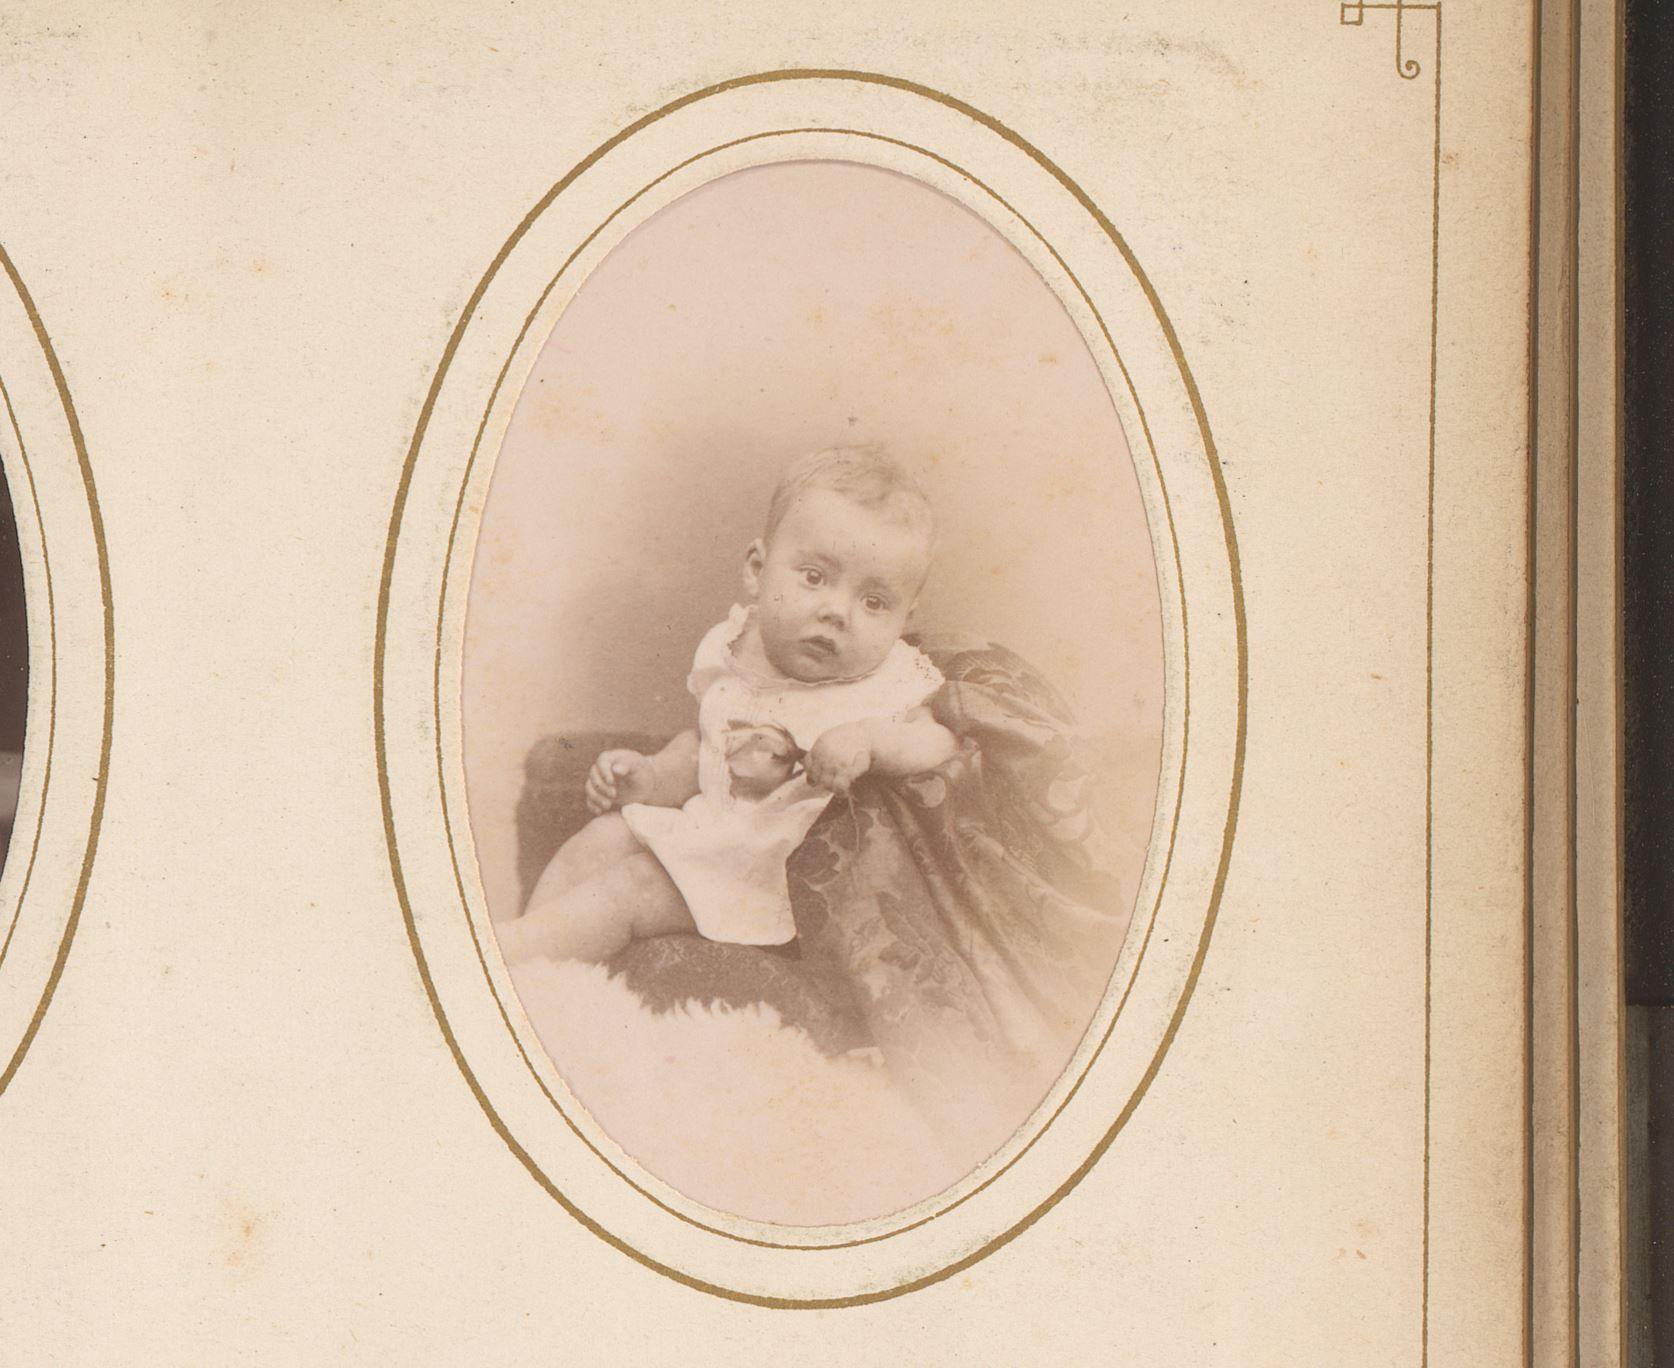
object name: carte de visite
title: Portret van een zittende baby, aangeduid als Georges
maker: j. ganz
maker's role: fotograaf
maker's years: 1872-1954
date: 1891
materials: cardboard, photographic support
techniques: albumen print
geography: brussels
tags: historical persons, infant, baby ~ the ages of man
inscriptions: inscription: ‘MÉDAILLE D'OR/ EXPOSITION D'ANVERS/ 1885/ J. Ganz/ 65, Rue Royale,/ près de la Colonne du Congrès./ BRUXELLES./ (...)/ Les ateliers se trouvent au Rez-de-Chaussée./ Les Clichés sont conservés.’, annotation: ‘Petit Georges à/ 61/2 mois/ 8 Xbre 1891.’